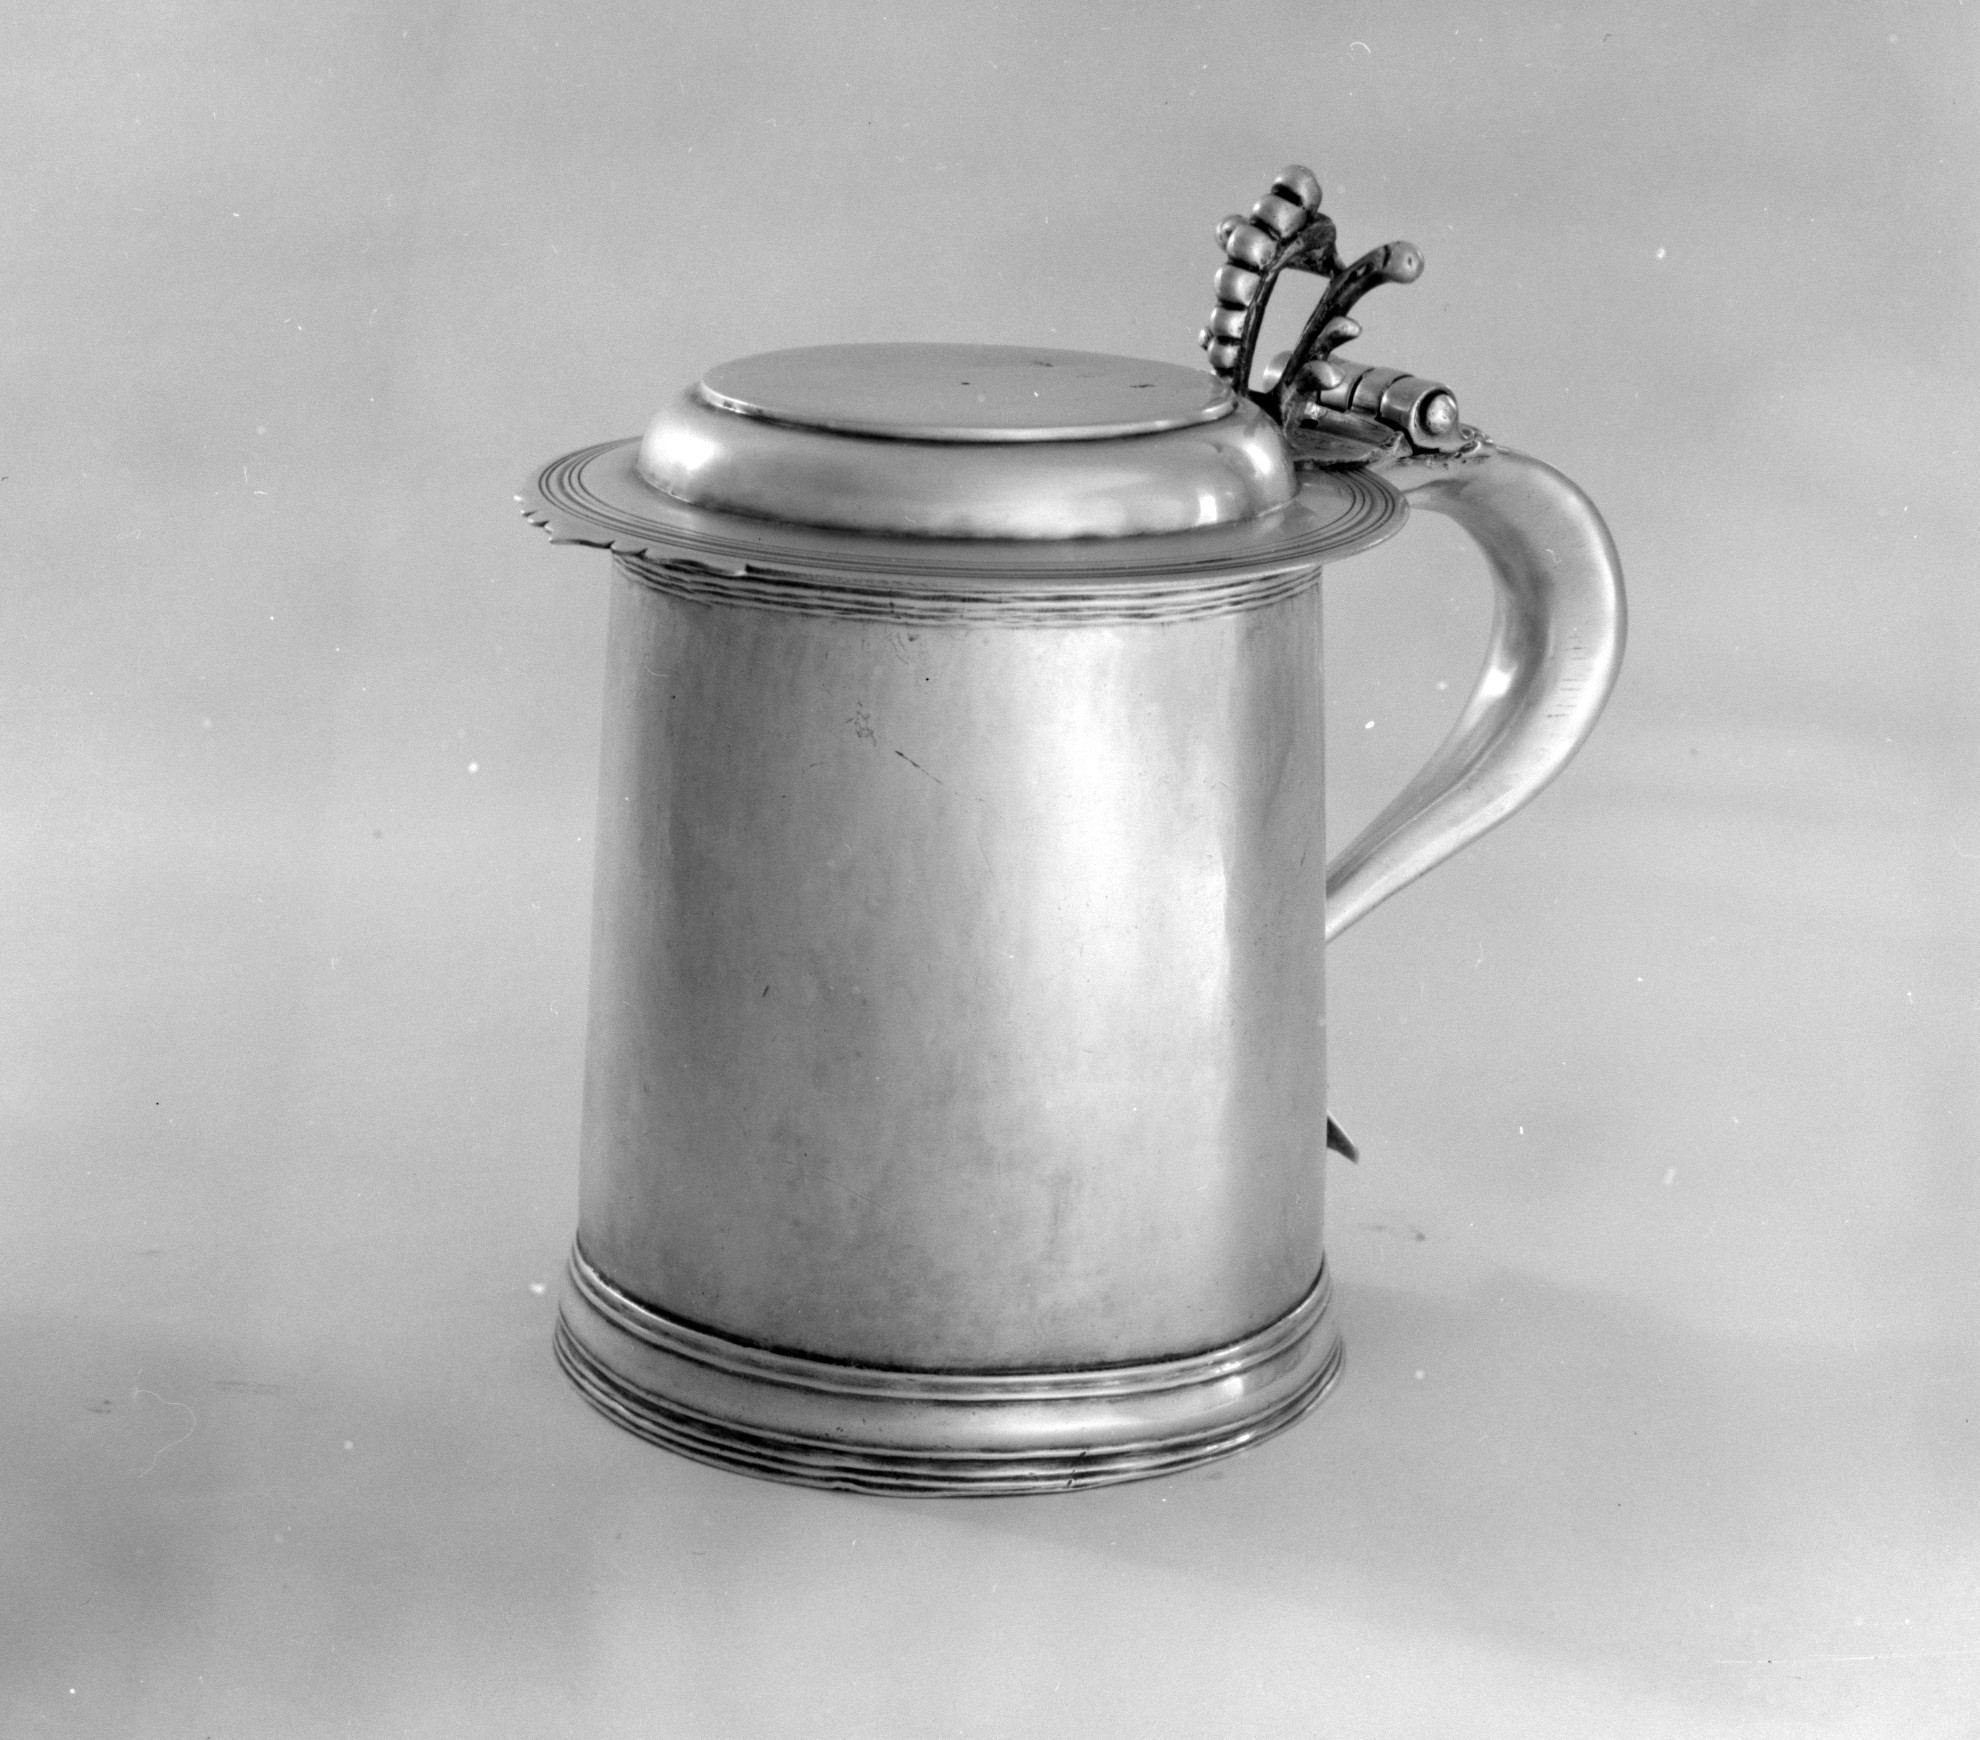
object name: tankard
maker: charles roades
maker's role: maker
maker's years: 1677-1707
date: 1679-1680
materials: silver